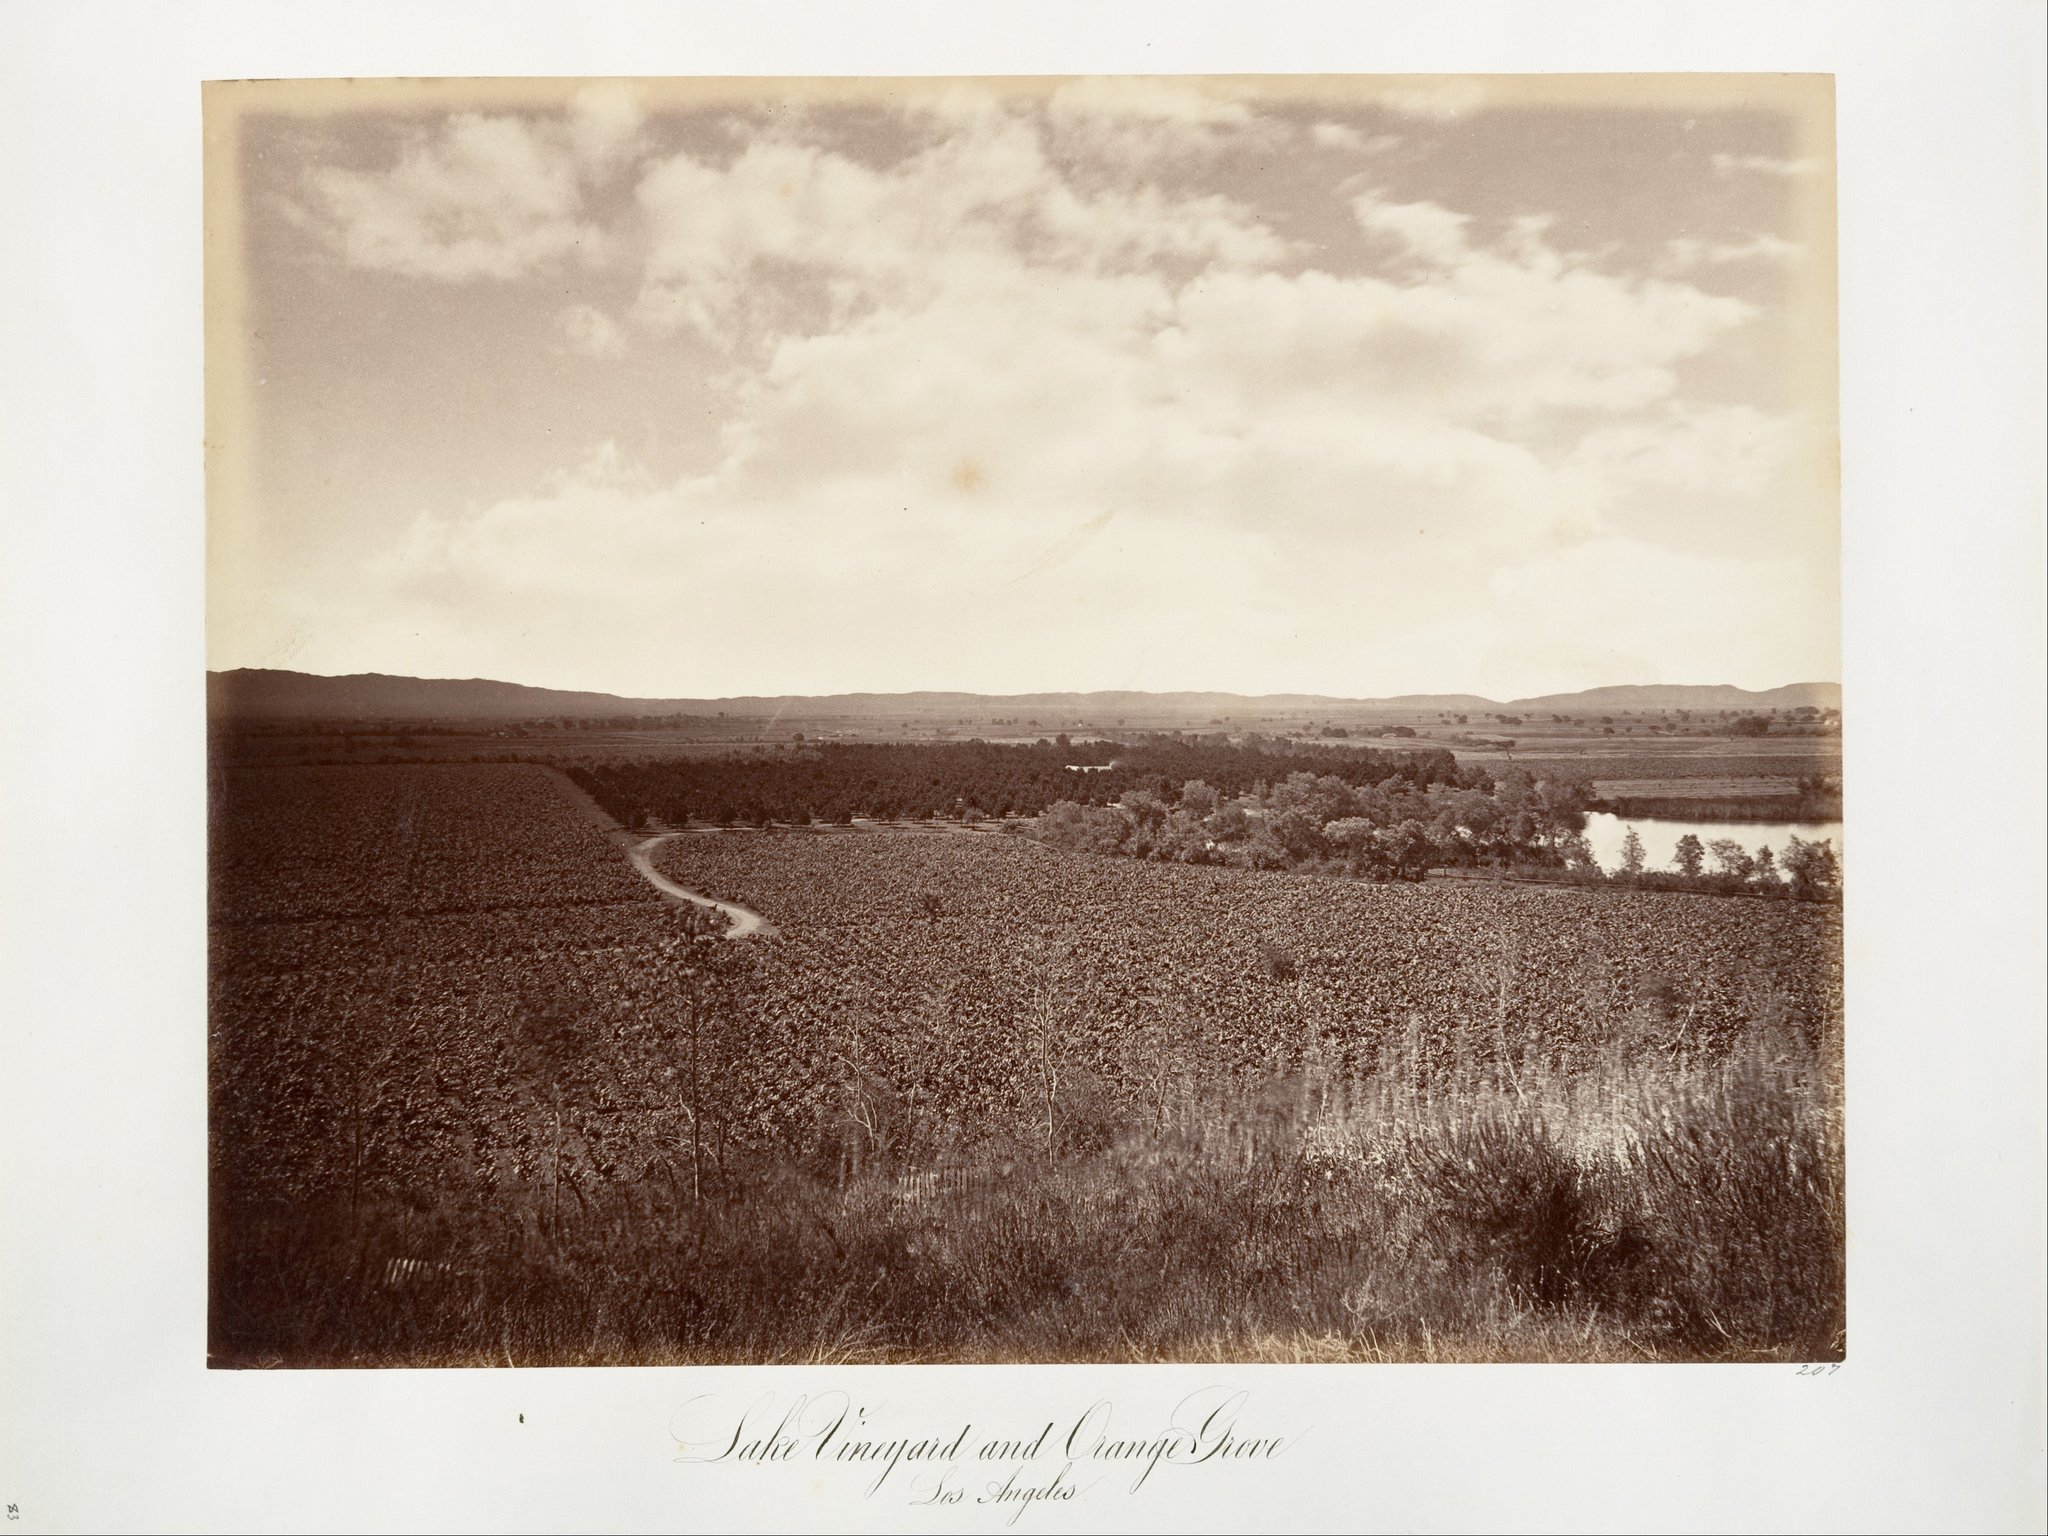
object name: photograph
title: Lake Vineyard and Orange Grove, Los Angeles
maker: carleton e. watkins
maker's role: artist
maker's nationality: american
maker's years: 1829-1916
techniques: albumen silver print, glass negative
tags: lakes,landscapes,plants